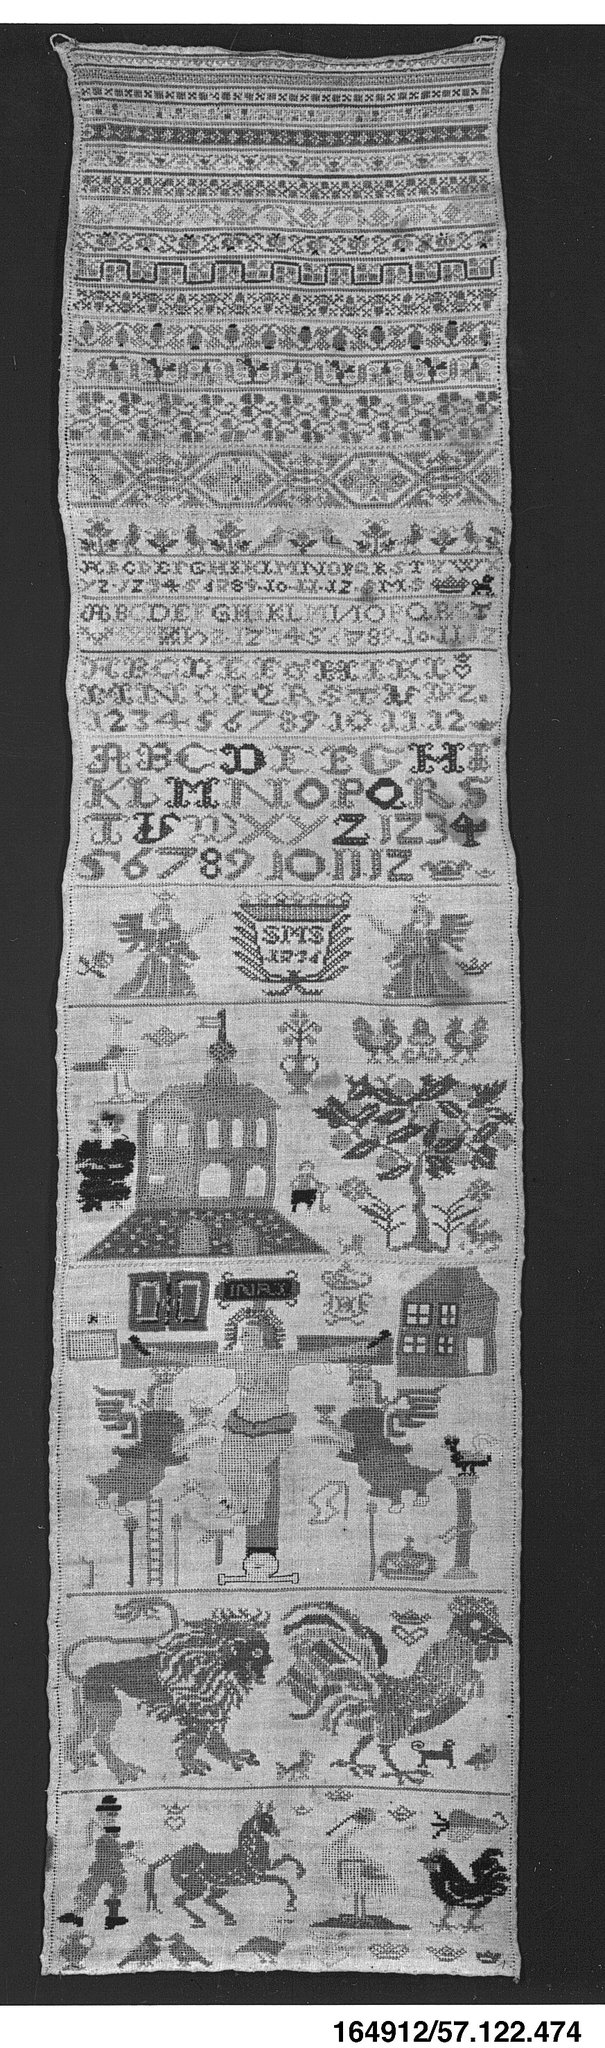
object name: sampler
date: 1734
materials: linen, metal thread, silk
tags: animals,jesus